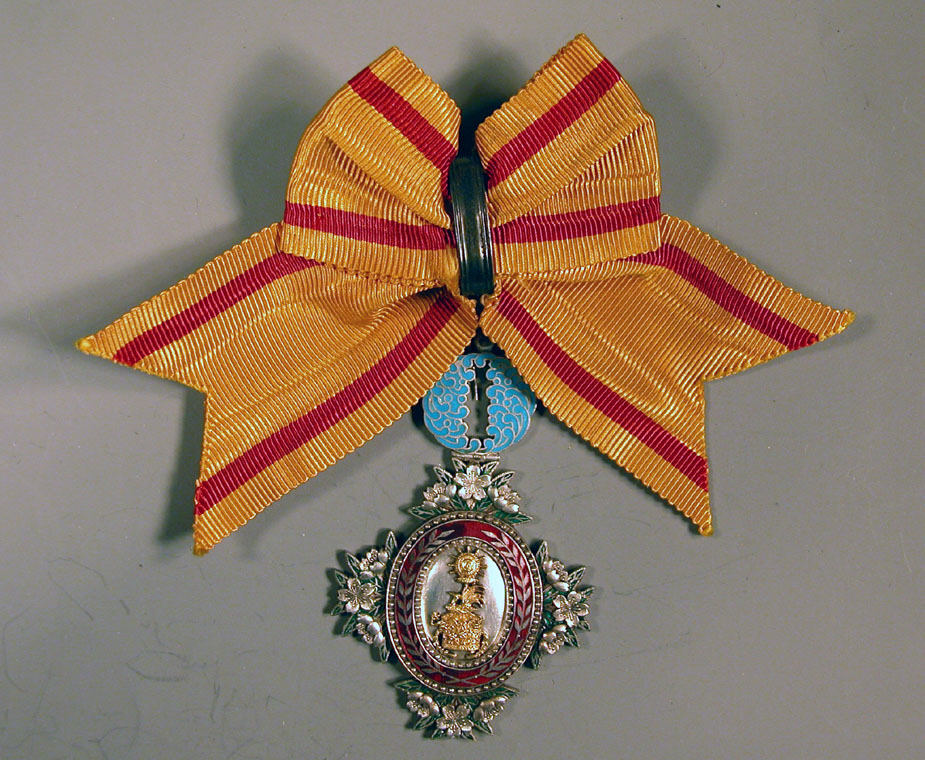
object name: medal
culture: japanese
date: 1867-1900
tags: flowers